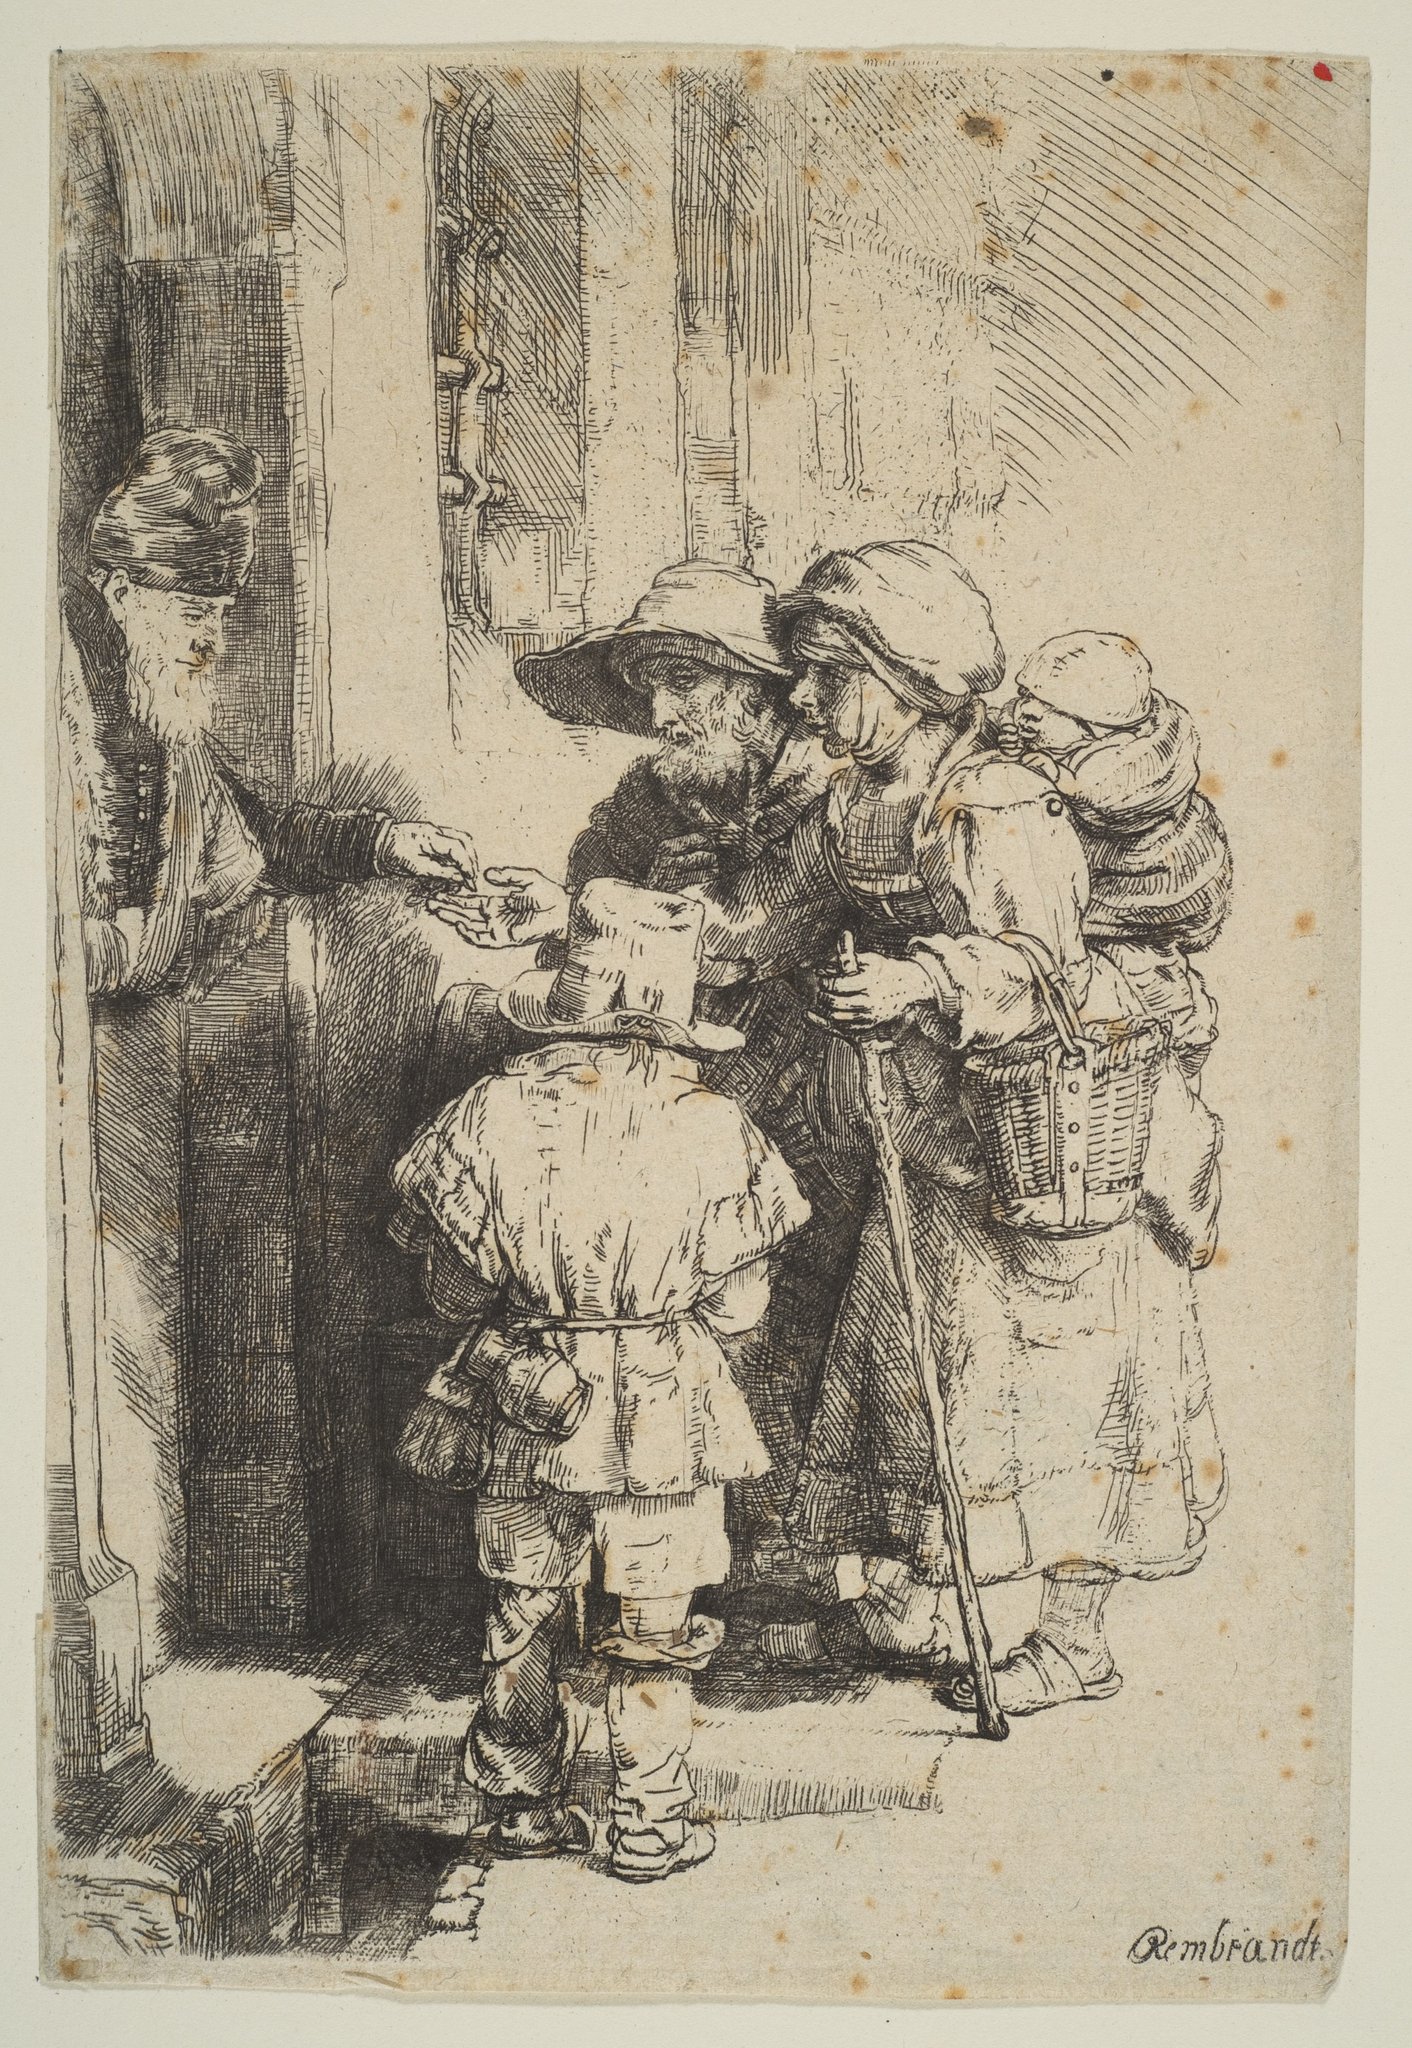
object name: print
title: Beggars Receiving Alms at the Door of a House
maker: rembrandt van rijn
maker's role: artist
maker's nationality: dutch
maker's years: 1606-1669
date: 1648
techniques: engraving, drypoint, etching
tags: infants,men,women